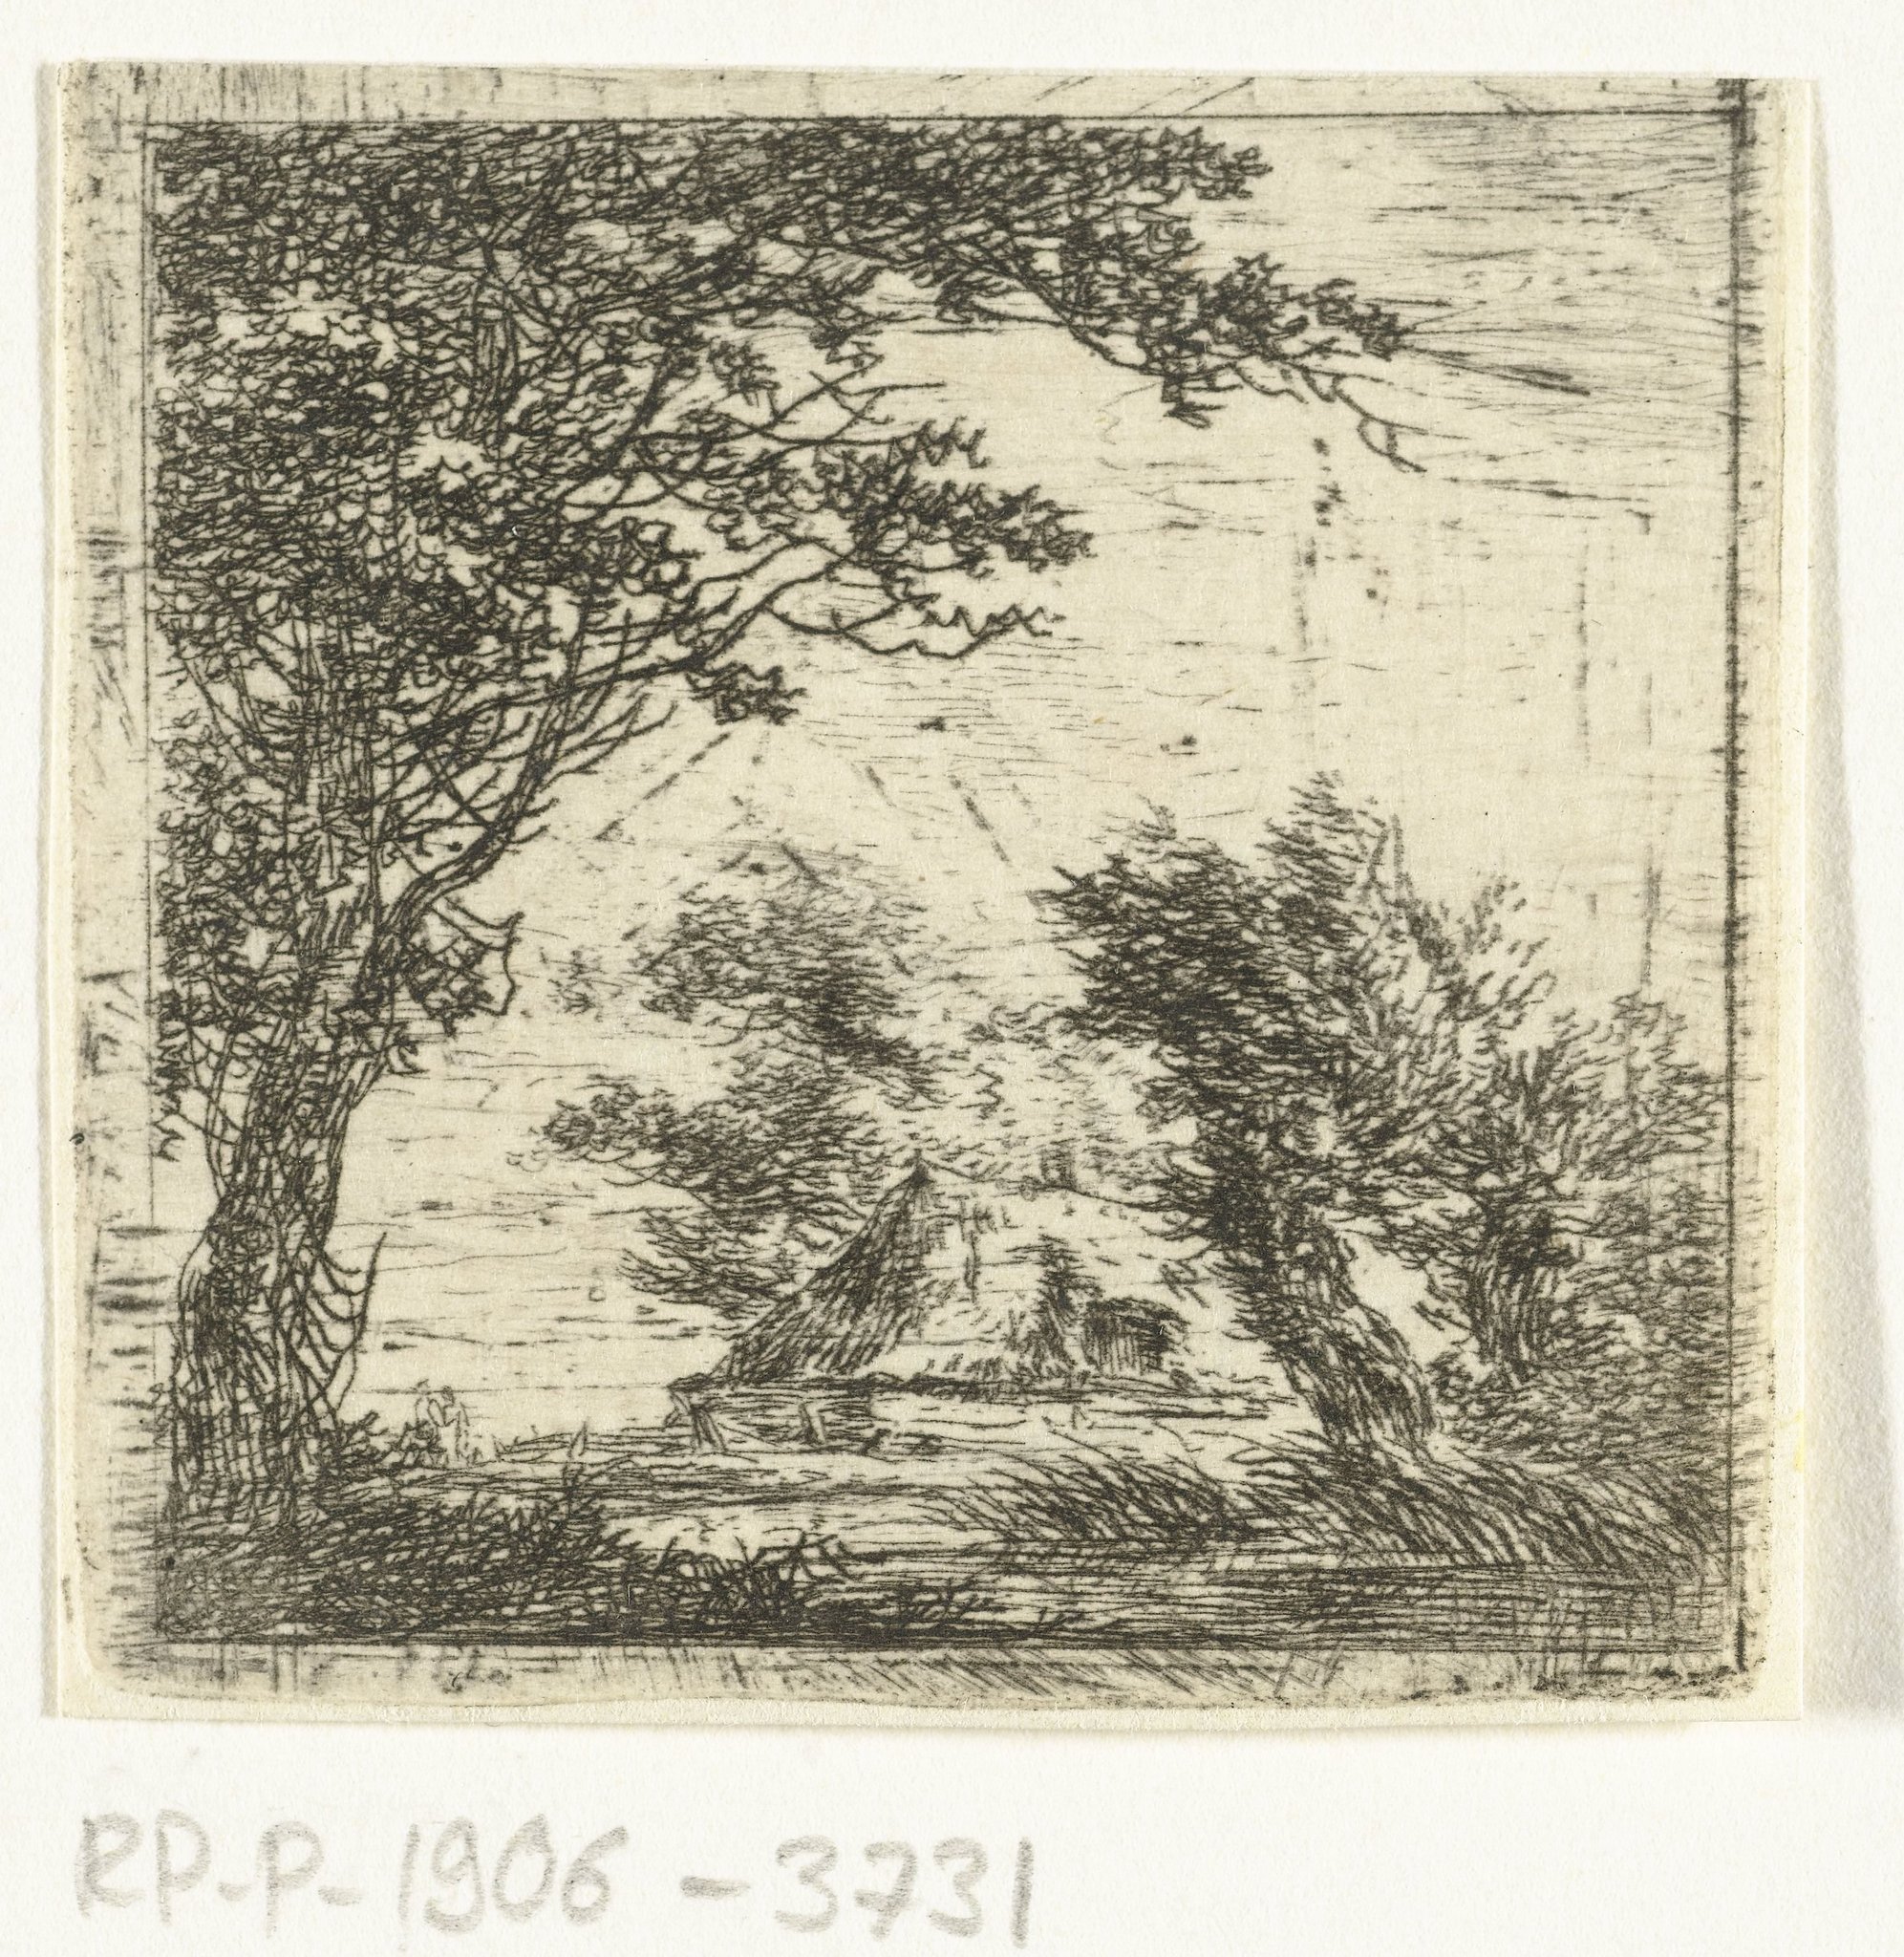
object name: print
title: Boerenwoning tussen bomen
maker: hermanus van brussel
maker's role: draughtsman, print maker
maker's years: 1763-1815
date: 1800-1815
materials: paper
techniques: etching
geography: netherlands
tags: landscapes in the temperate zone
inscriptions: collector's mark: Lugt 2228